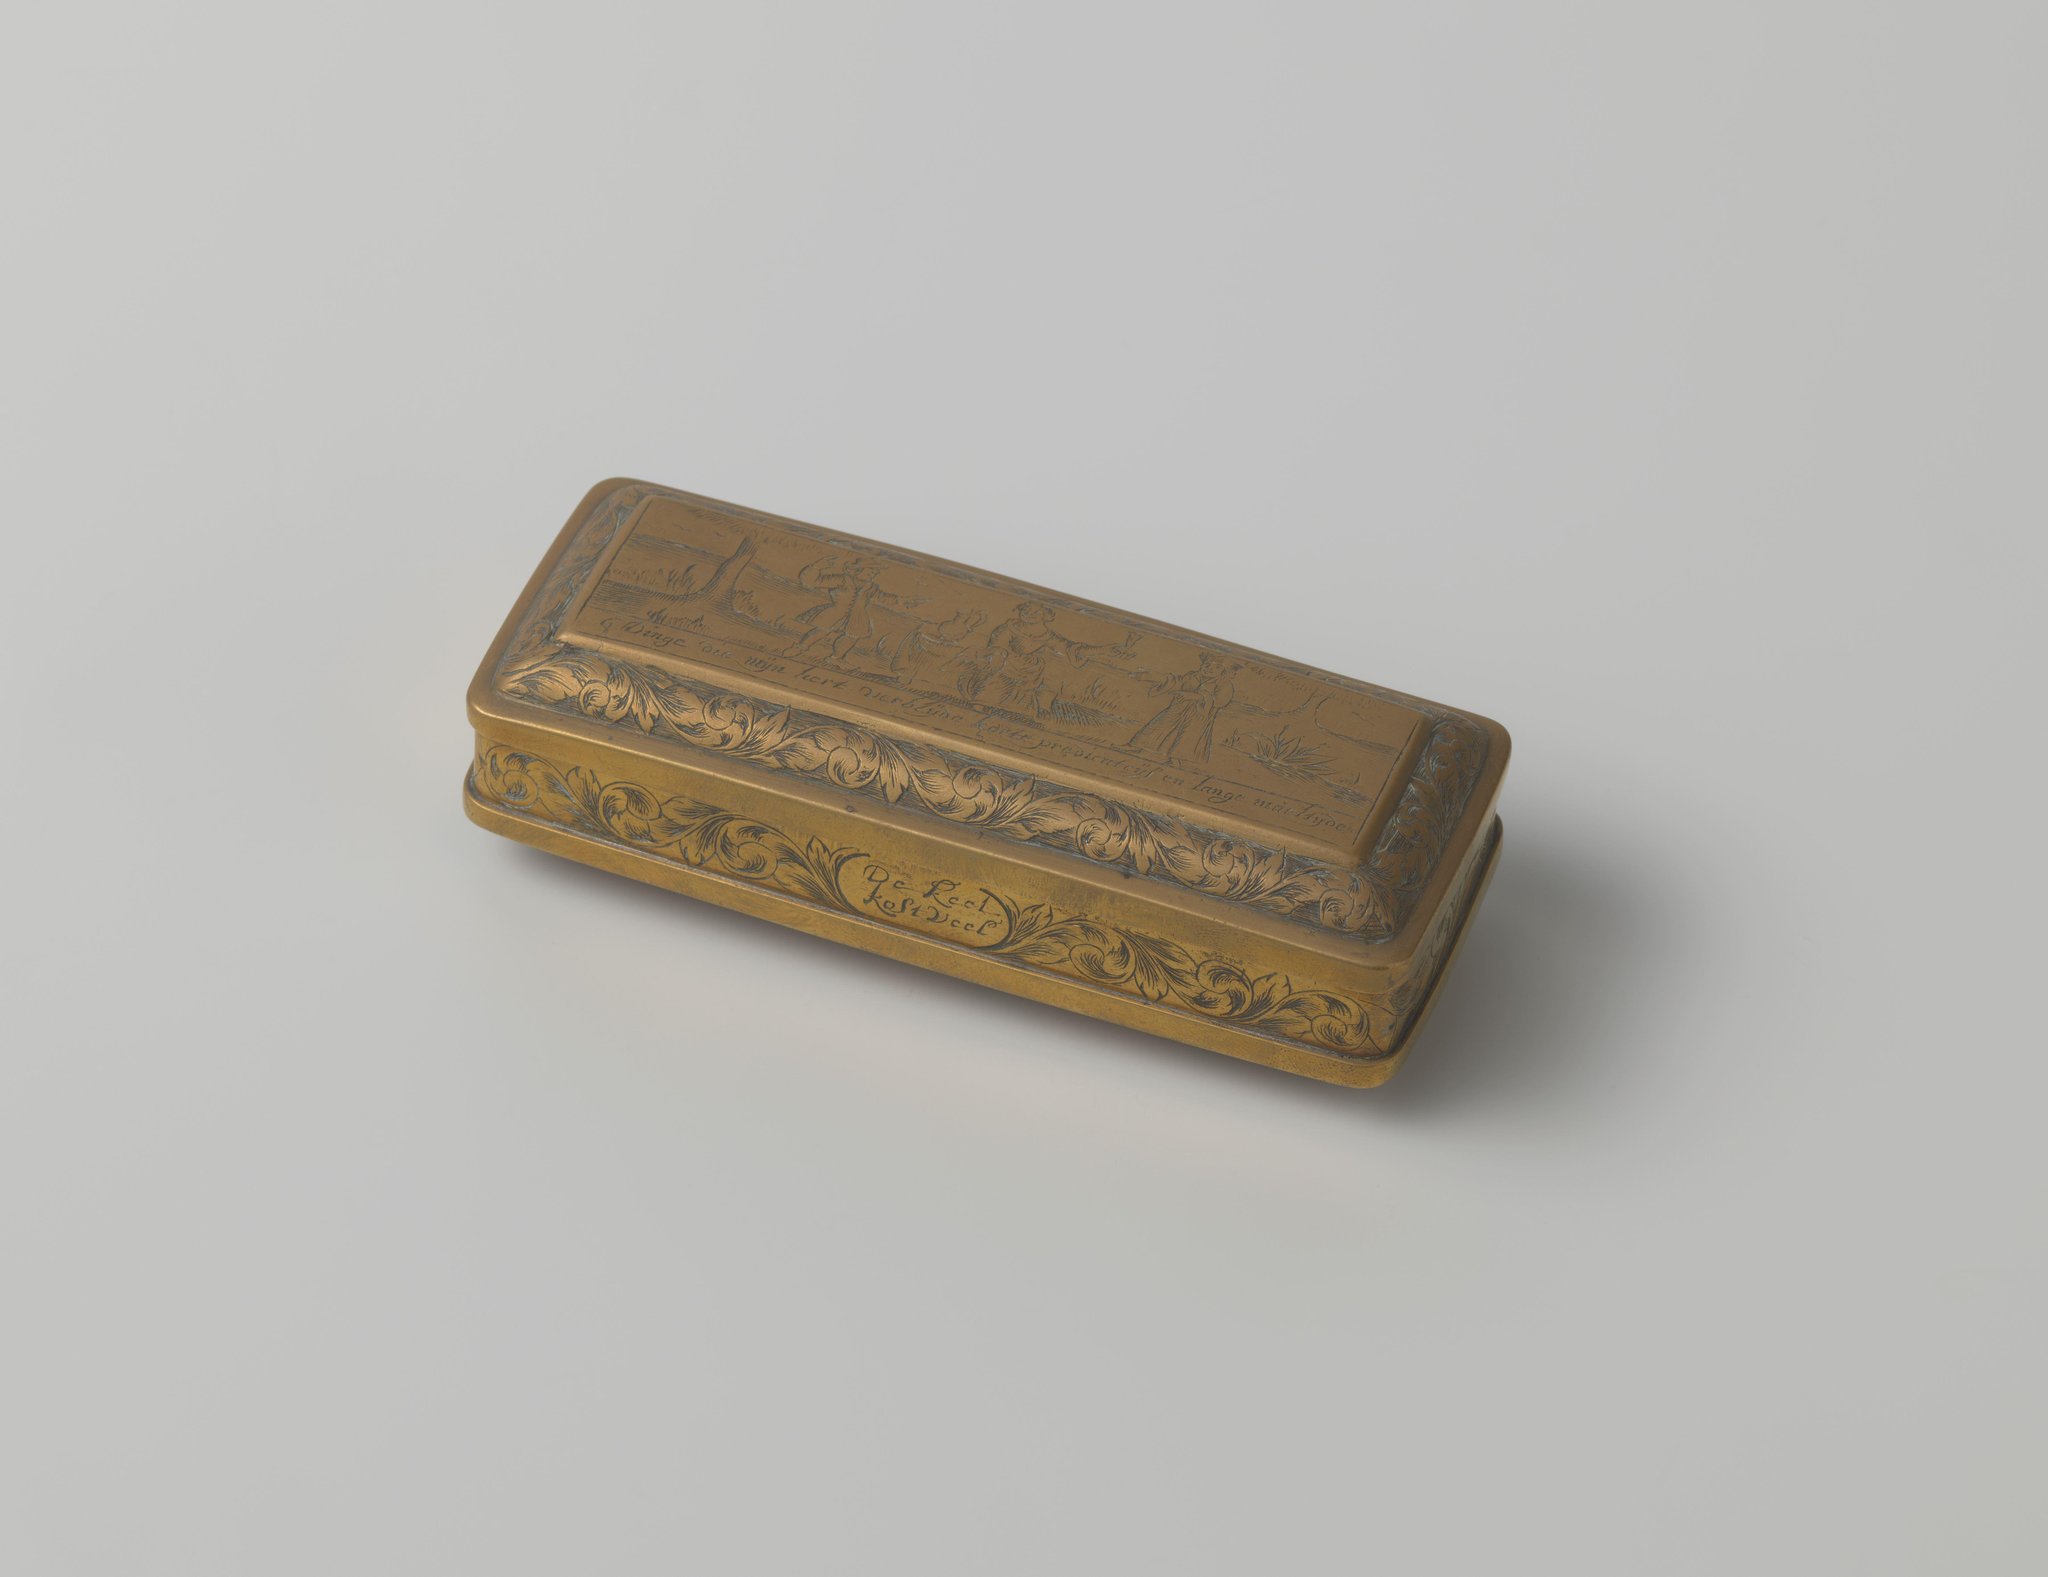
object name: tobacco box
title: Tabaksdoos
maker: Anonymous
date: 1700-1725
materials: brass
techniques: engraving, striking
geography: netherlands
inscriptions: inscription: ‘Jong vlees verse vis een moije meijt en wijn op den dis’, inscription: ‘De Keel kost veel’, inscription: ‘6 Dinge die mijn hert verblijde korte predicatcijs en lange maeltijde’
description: Het voorwerp is samengesteld uit drie delen: de bodem, de wand en het deksel. Zij hebben een gegraveerde versiering en voorstelling. Deksel en bodem lopen bij de kanten naar het midden toe bol op en zijn verder plat. Zij worden afgesloten door verticale gladde randen, die de wand van de doos omvatten. De bolle delen van deksel en bodem hebben gegraveerd doorlopend rankenornament. Op het deksel ene tafereel van een man, een vrouw met een glas in de hand en een geestelijke en het opschrift '6 Dinge die mijn hert verblijde korte predicatcijs en lange maeltijde.' Op de bodem een voorstelling van een paartje en een man met het opschrift 'Jong vlees verse vis een moije meijt en wijn op den dis.' De wand heeft gegraveerd rankenornament en aan de voorkant het opschrift 'De Keel kost veel.'